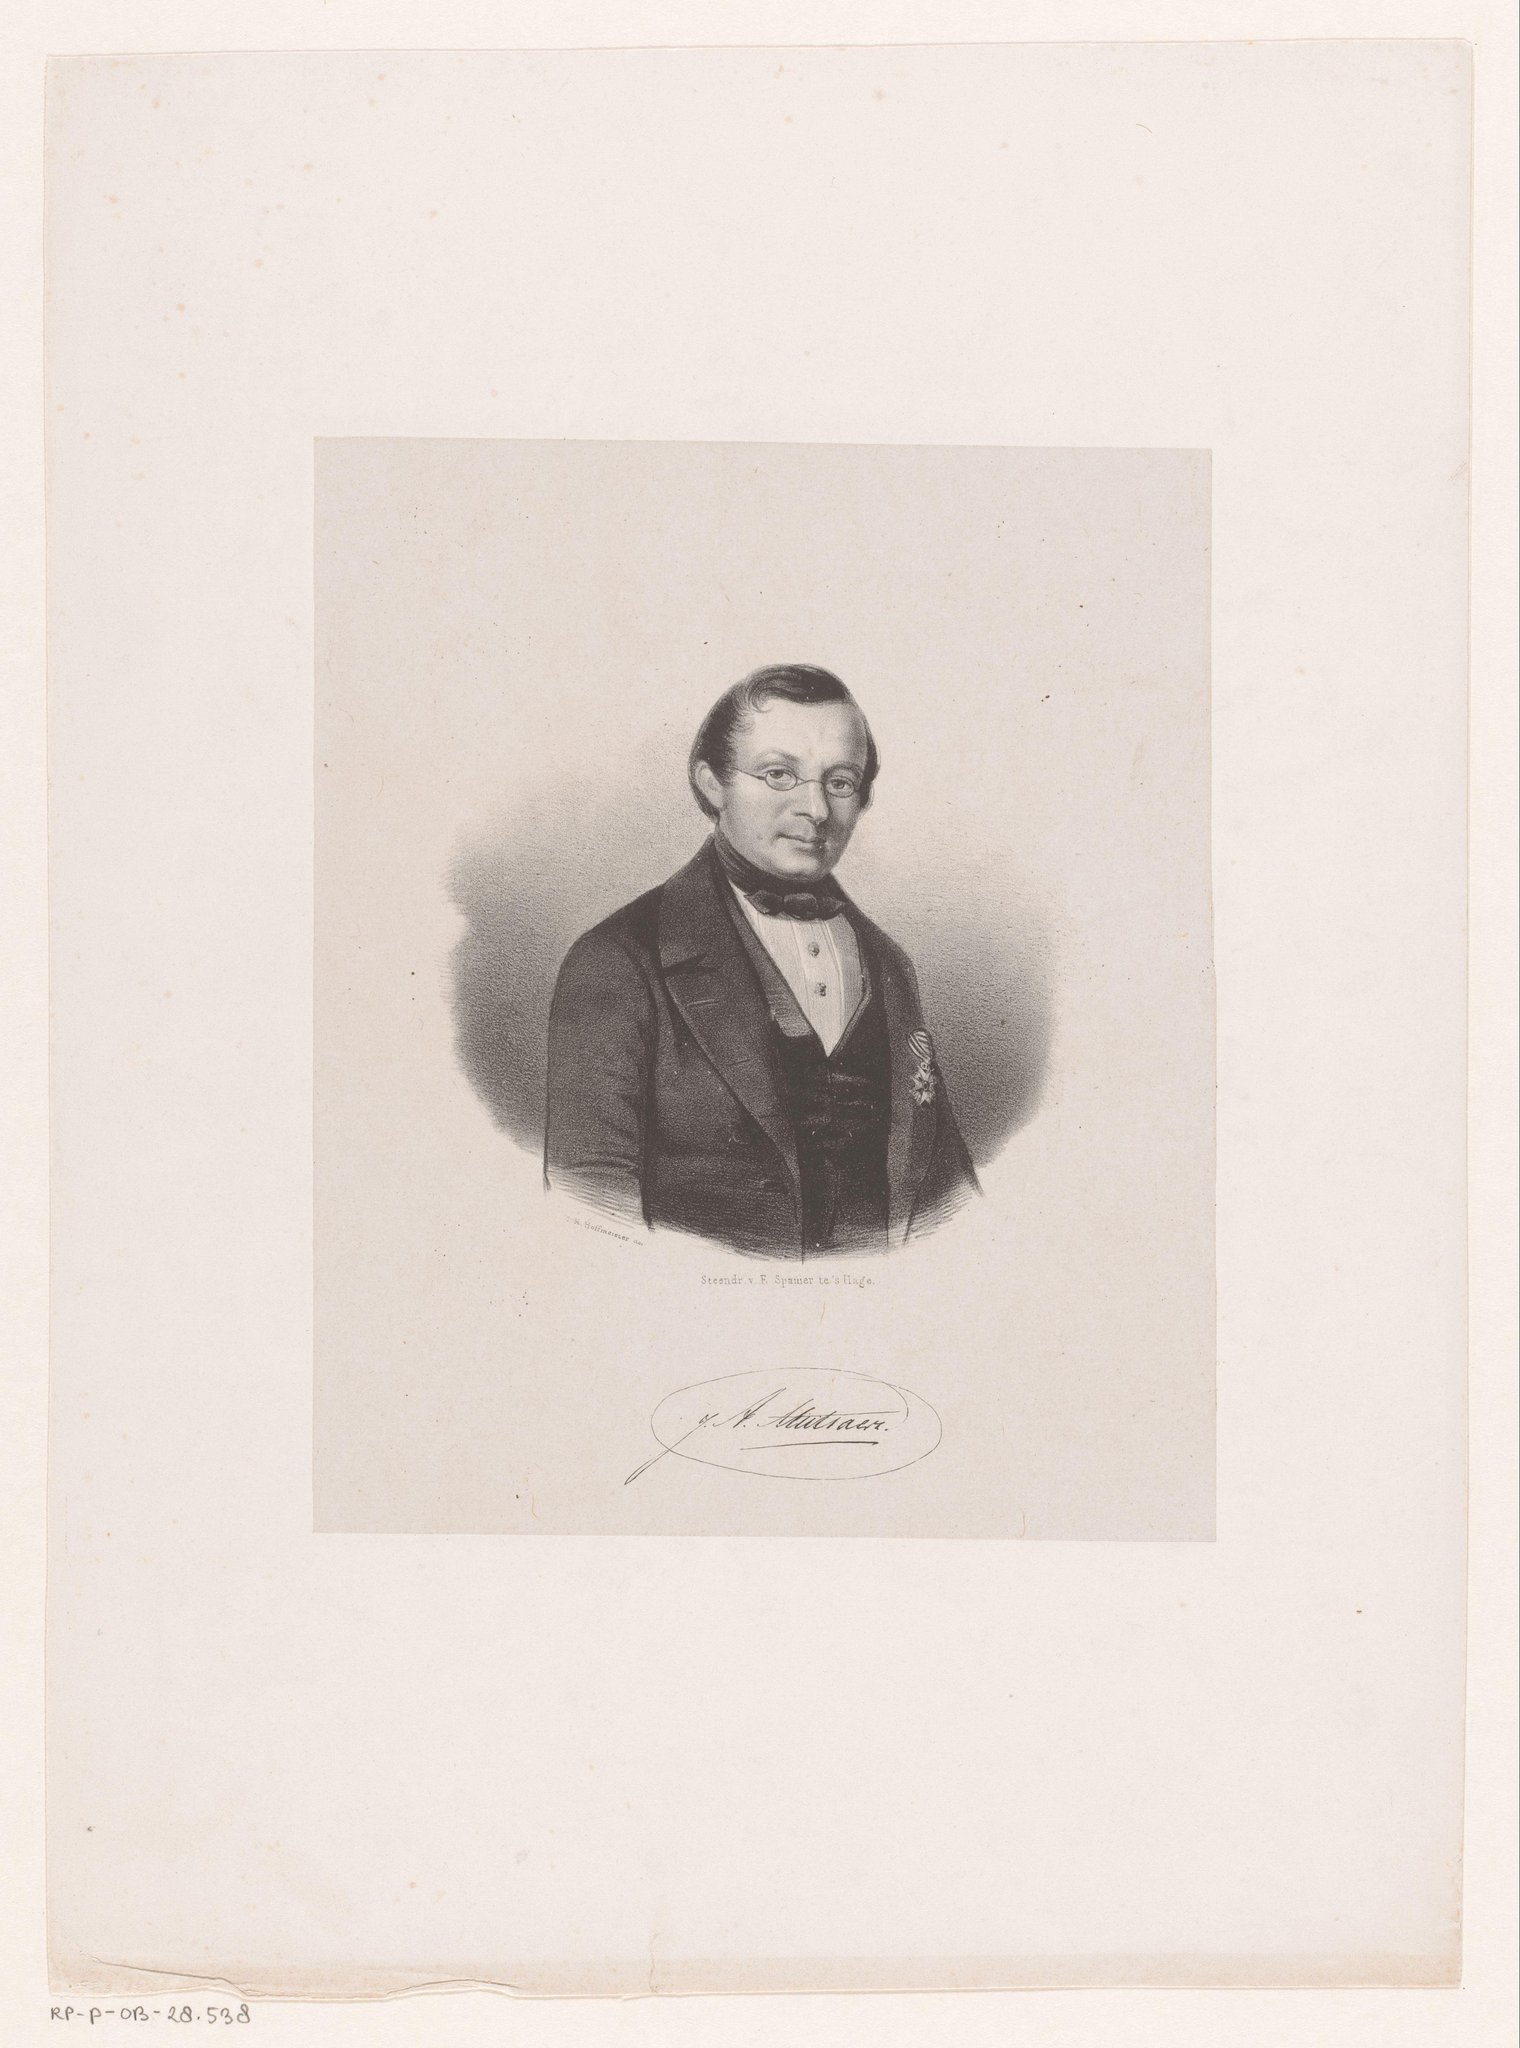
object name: print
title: Portret van Jacobus Arnoldus Mutsaers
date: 1843-1863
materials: paper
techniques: lithograph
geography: netherlands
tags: the hague, politician, eyeglasses, spectacles, knighthood order, historical persons (+ (full) bust portrait)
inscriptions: collector's mark: Lugt 2228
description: De geportretteerde draagt een bril en een commandeurskruis op de revers van zijn jas. Onder het portret zijn signatuur.